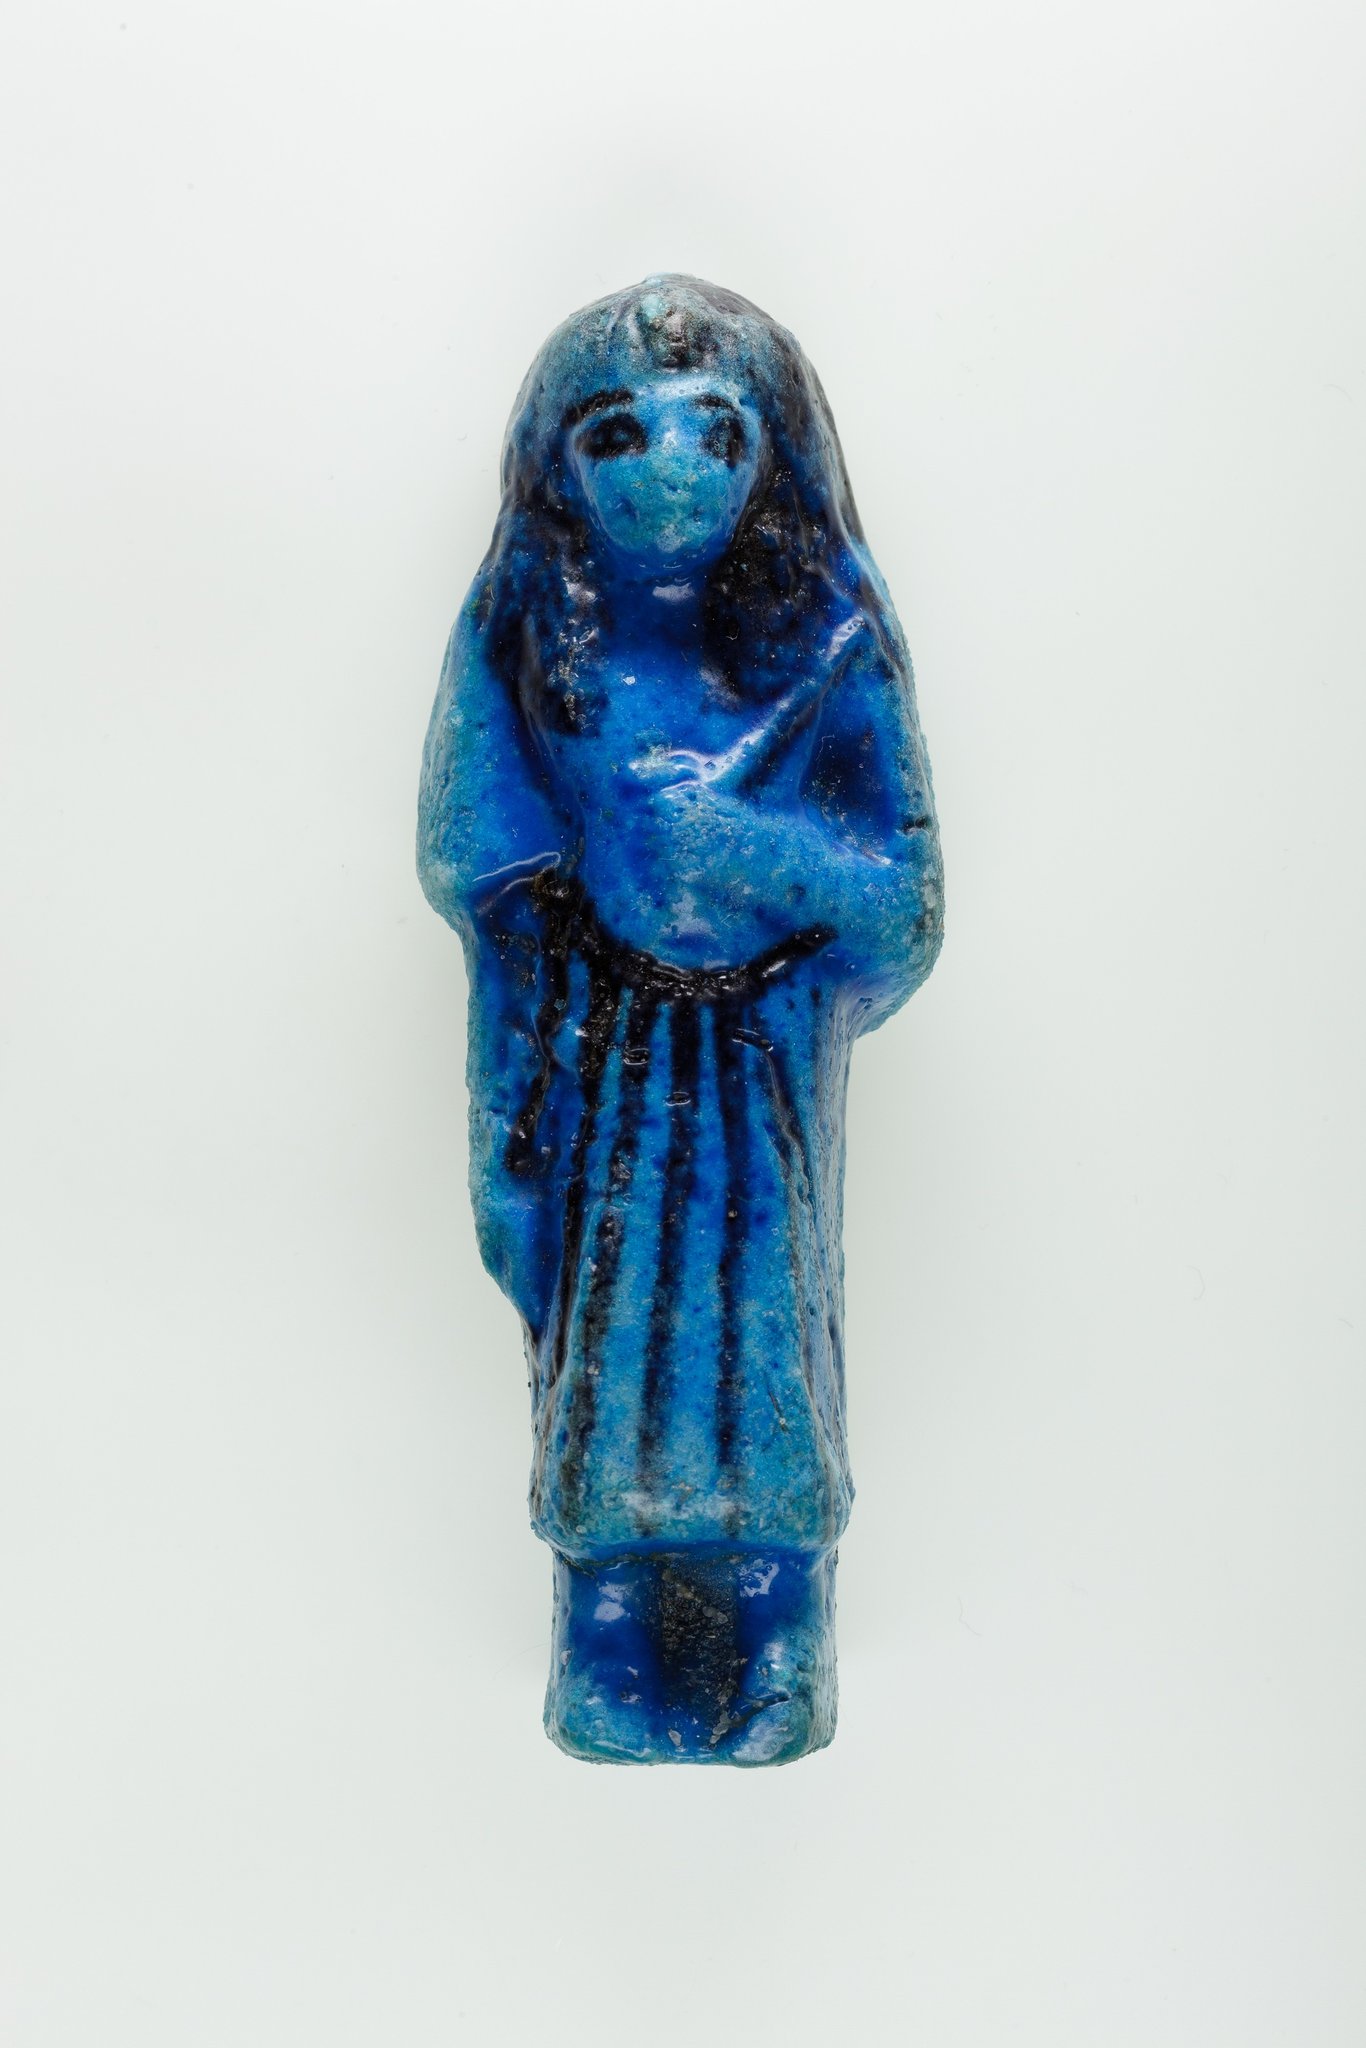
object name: shabti, overseer, nauny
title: Overseer Shabti of Nauny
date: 1050 BCE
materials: faience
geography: egypt